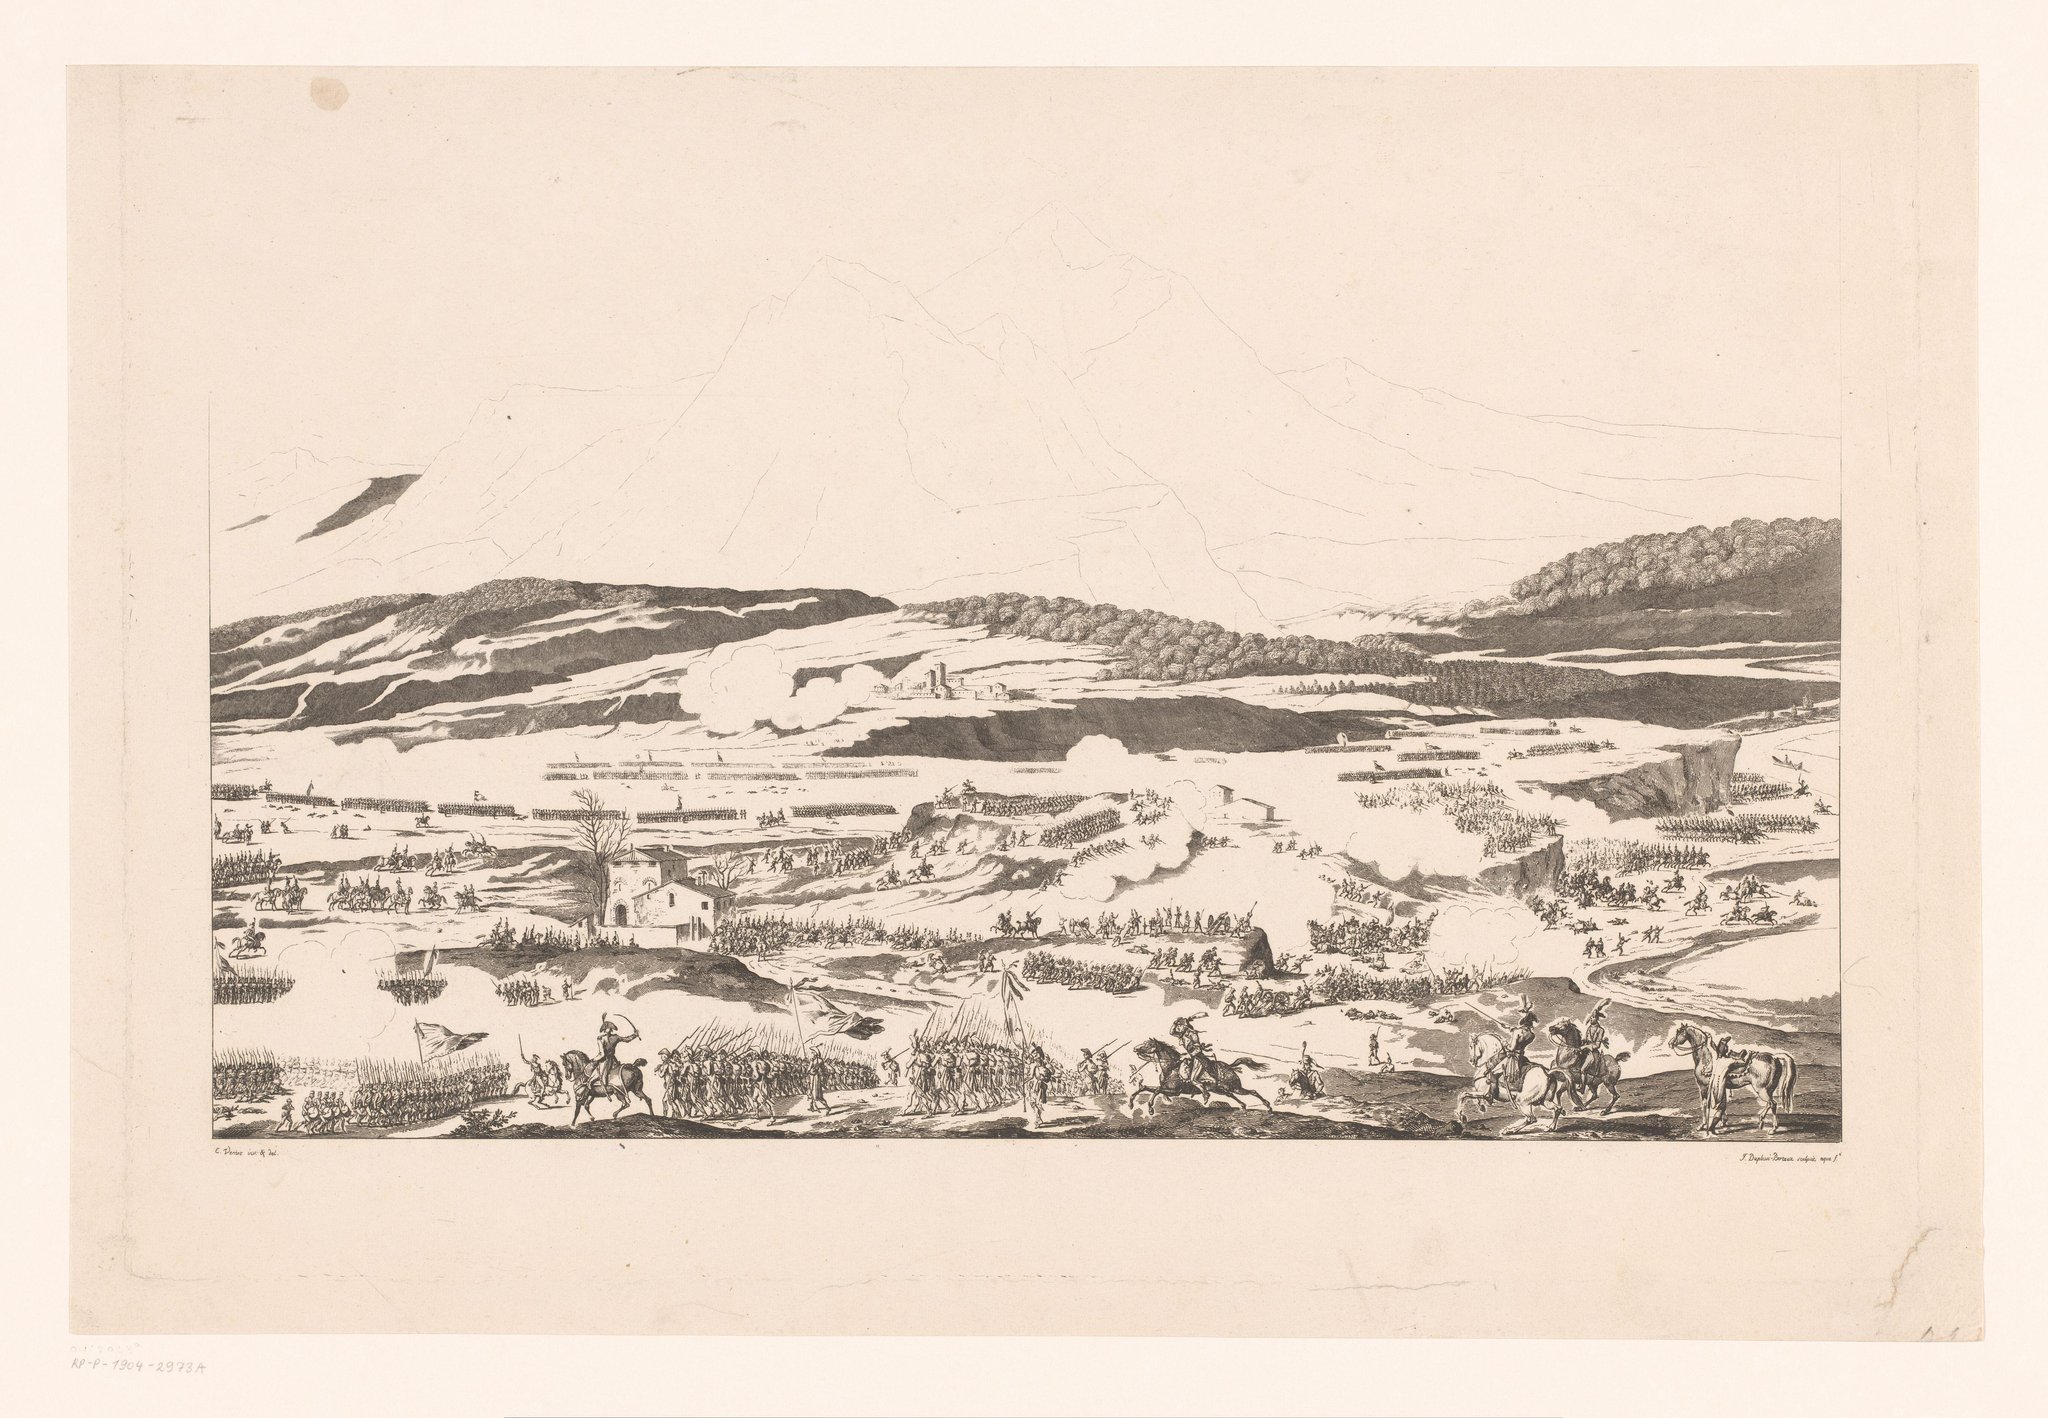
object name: print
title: Slag bij Rivoli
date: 1796-1818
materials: paper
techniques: aquatint, etching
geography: france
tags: battle, mountains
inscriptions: watermark, collector's mark: Lugt 2228